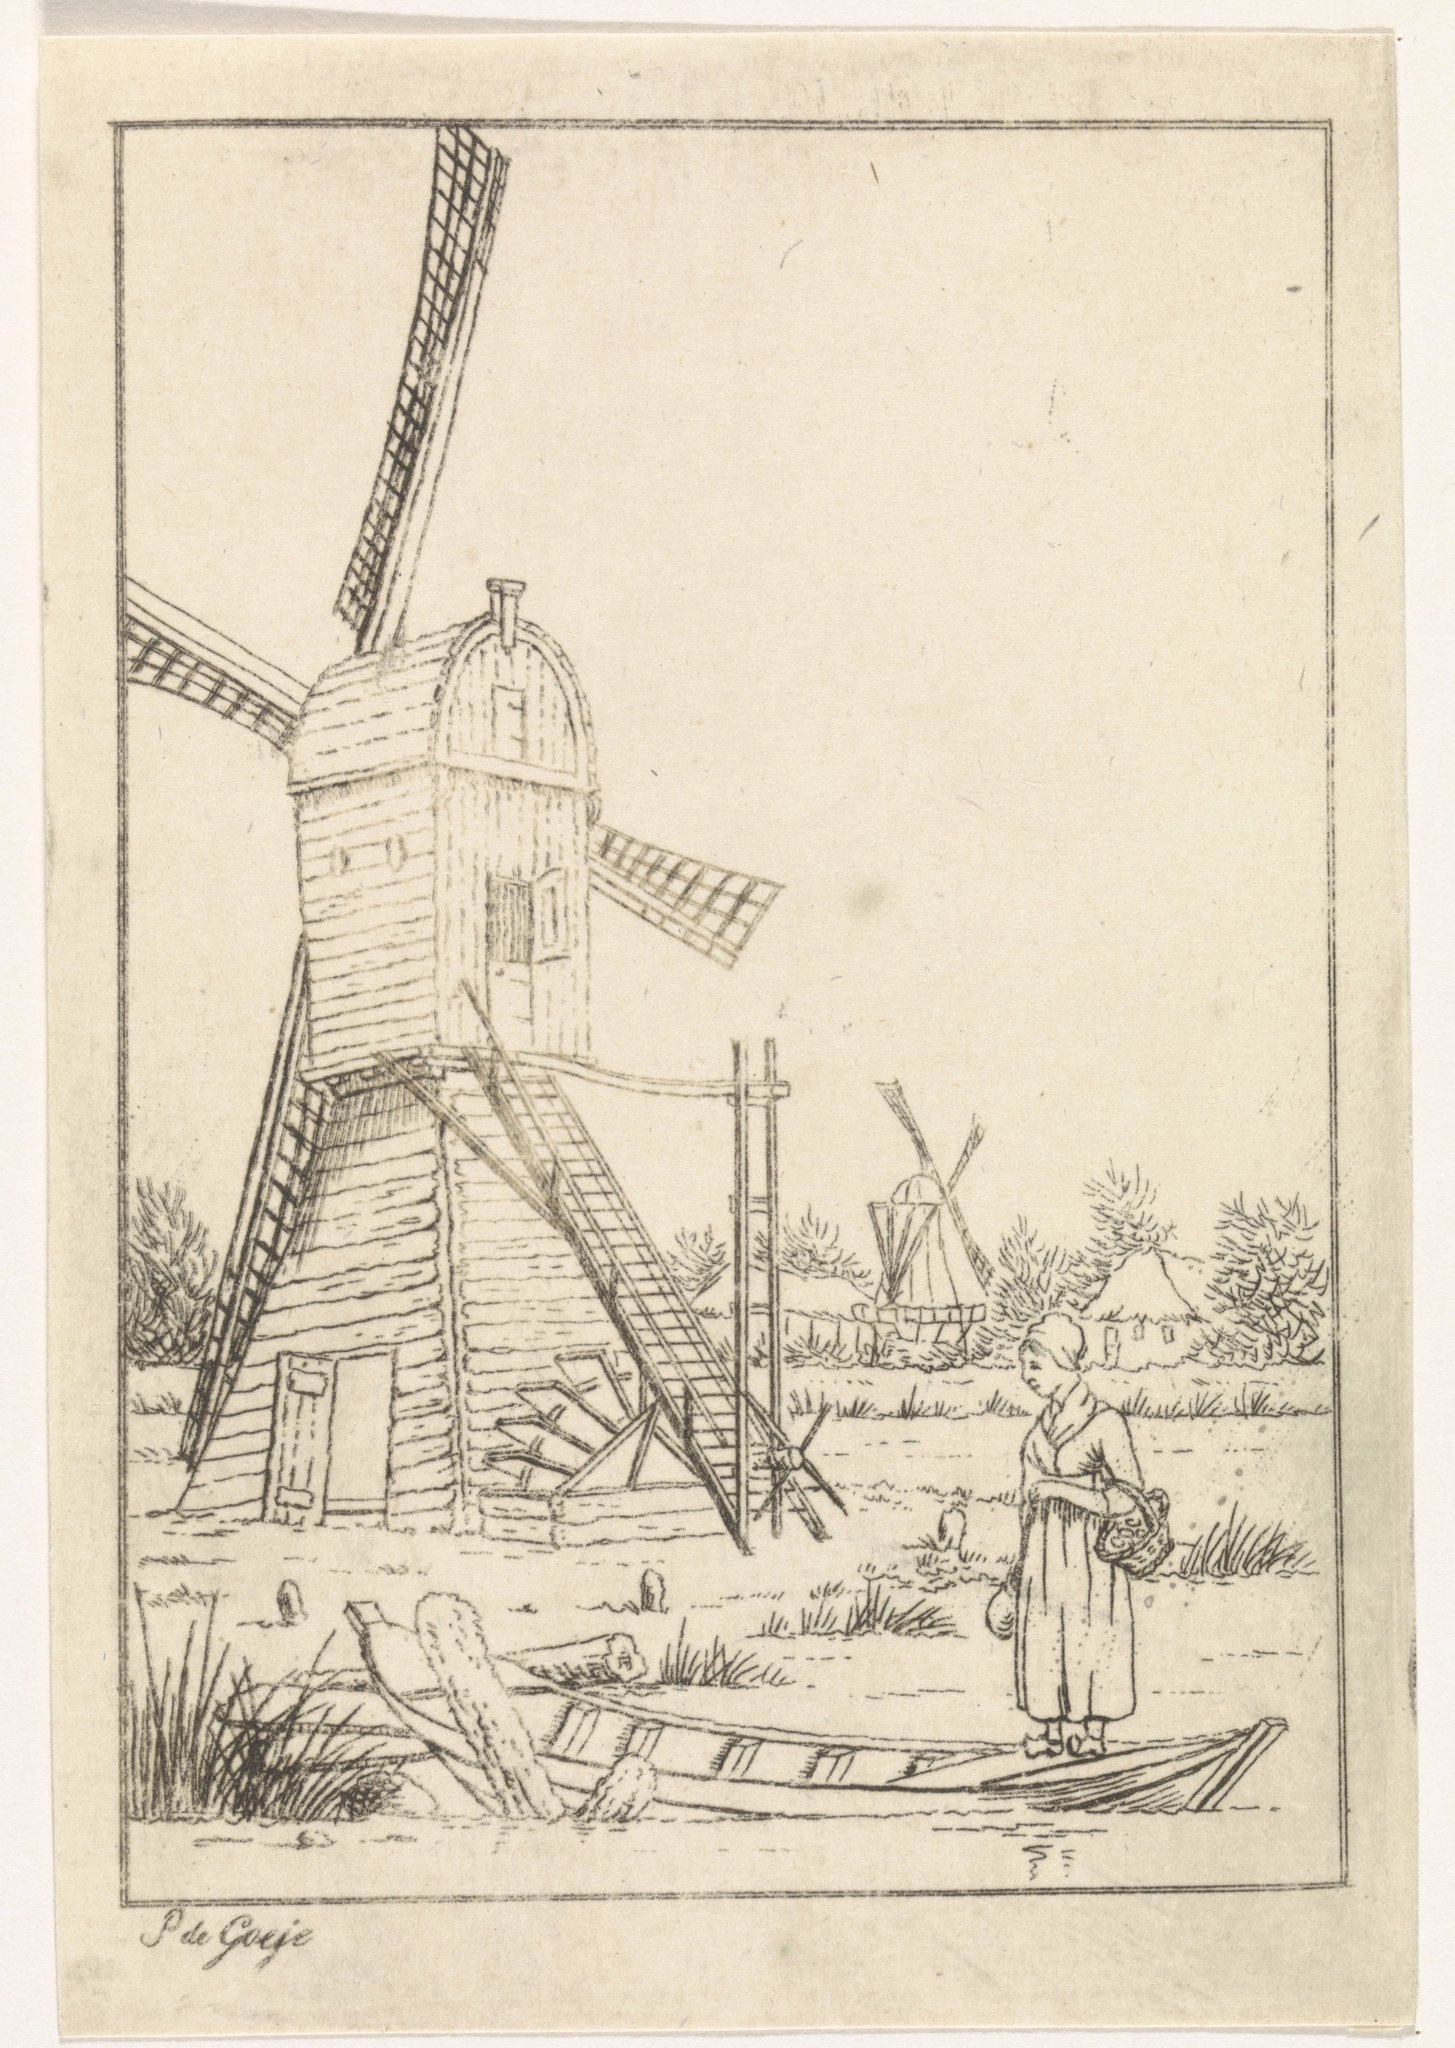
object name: print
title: Winterlandschap met molen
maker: pieter de goeje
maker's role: draughtsman, print maker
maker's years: 1789-1859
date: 1789-1859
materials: paper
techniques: etching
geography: amsterdam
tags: winter landscape; landscape symbolizing winter (the four seasons of the year), windmill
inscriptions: collector's mark: Lugt 2228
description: Een winterlandschap met een molen. Op de voorgrond een vrouw in een bootje.